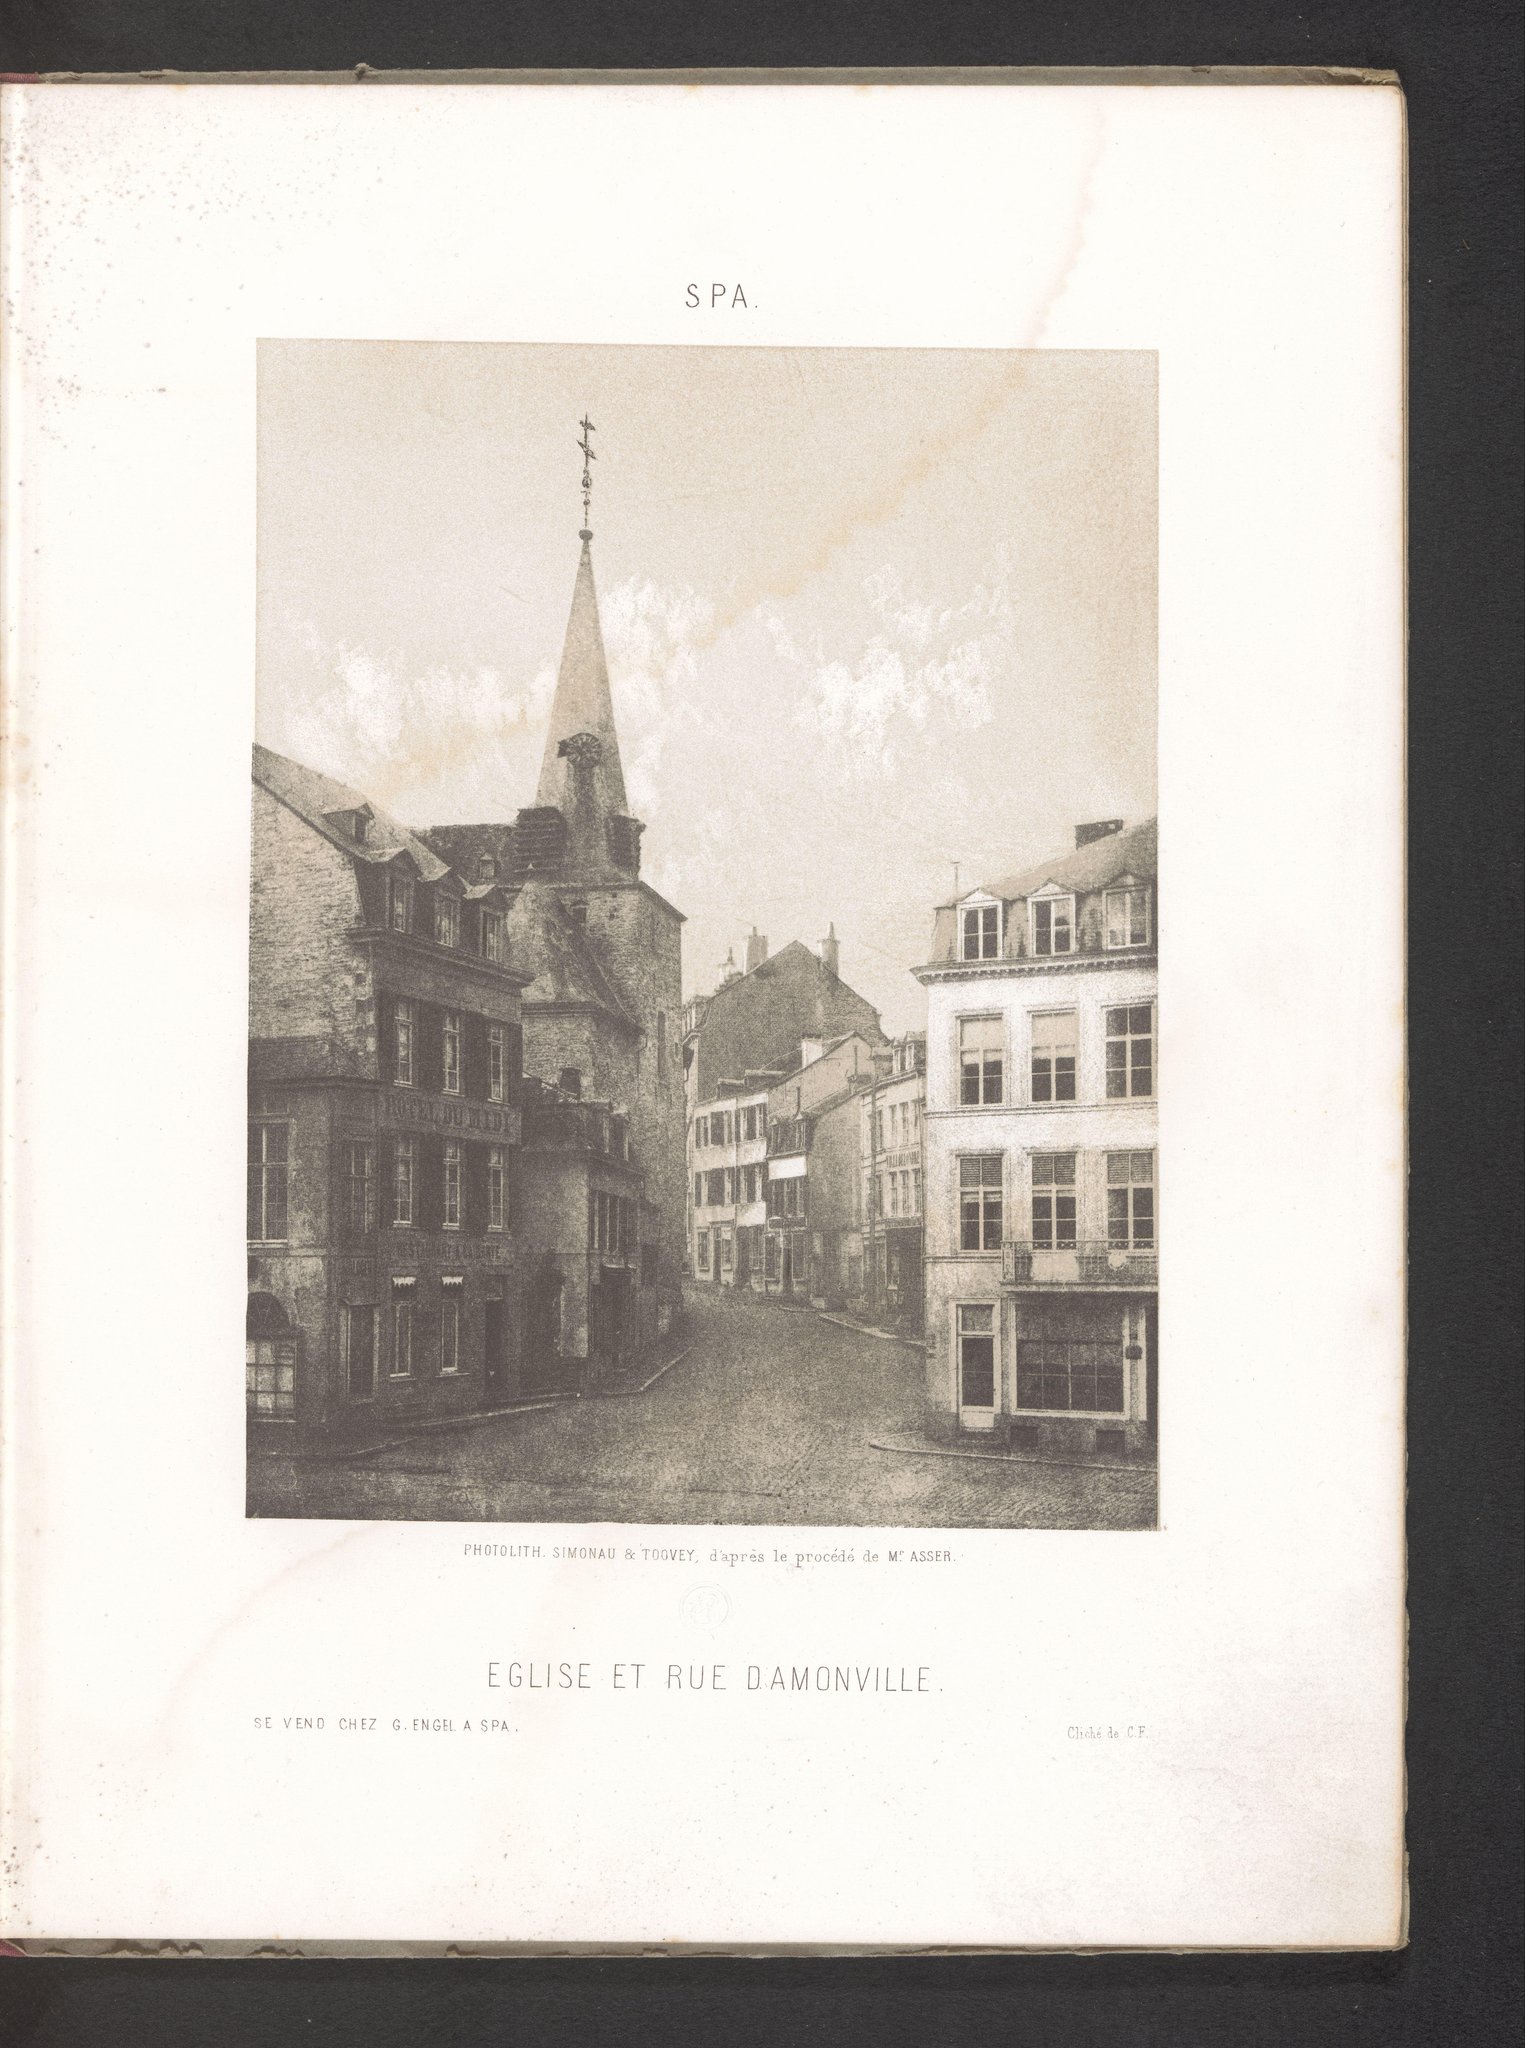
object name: page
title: Spa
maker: c.f.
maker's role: fotograaf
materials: paper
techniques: photolithography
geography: brussels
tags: church (exterior), street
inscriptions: inscription: ‘PHOTOLITH. SIMONAU & TOOVEY, d'après le procédé de Mr. ASSER.’, inscription: ‘SE VEND CHEZ F. ENGEL A SPA.’, collector's mark: ‘EA’